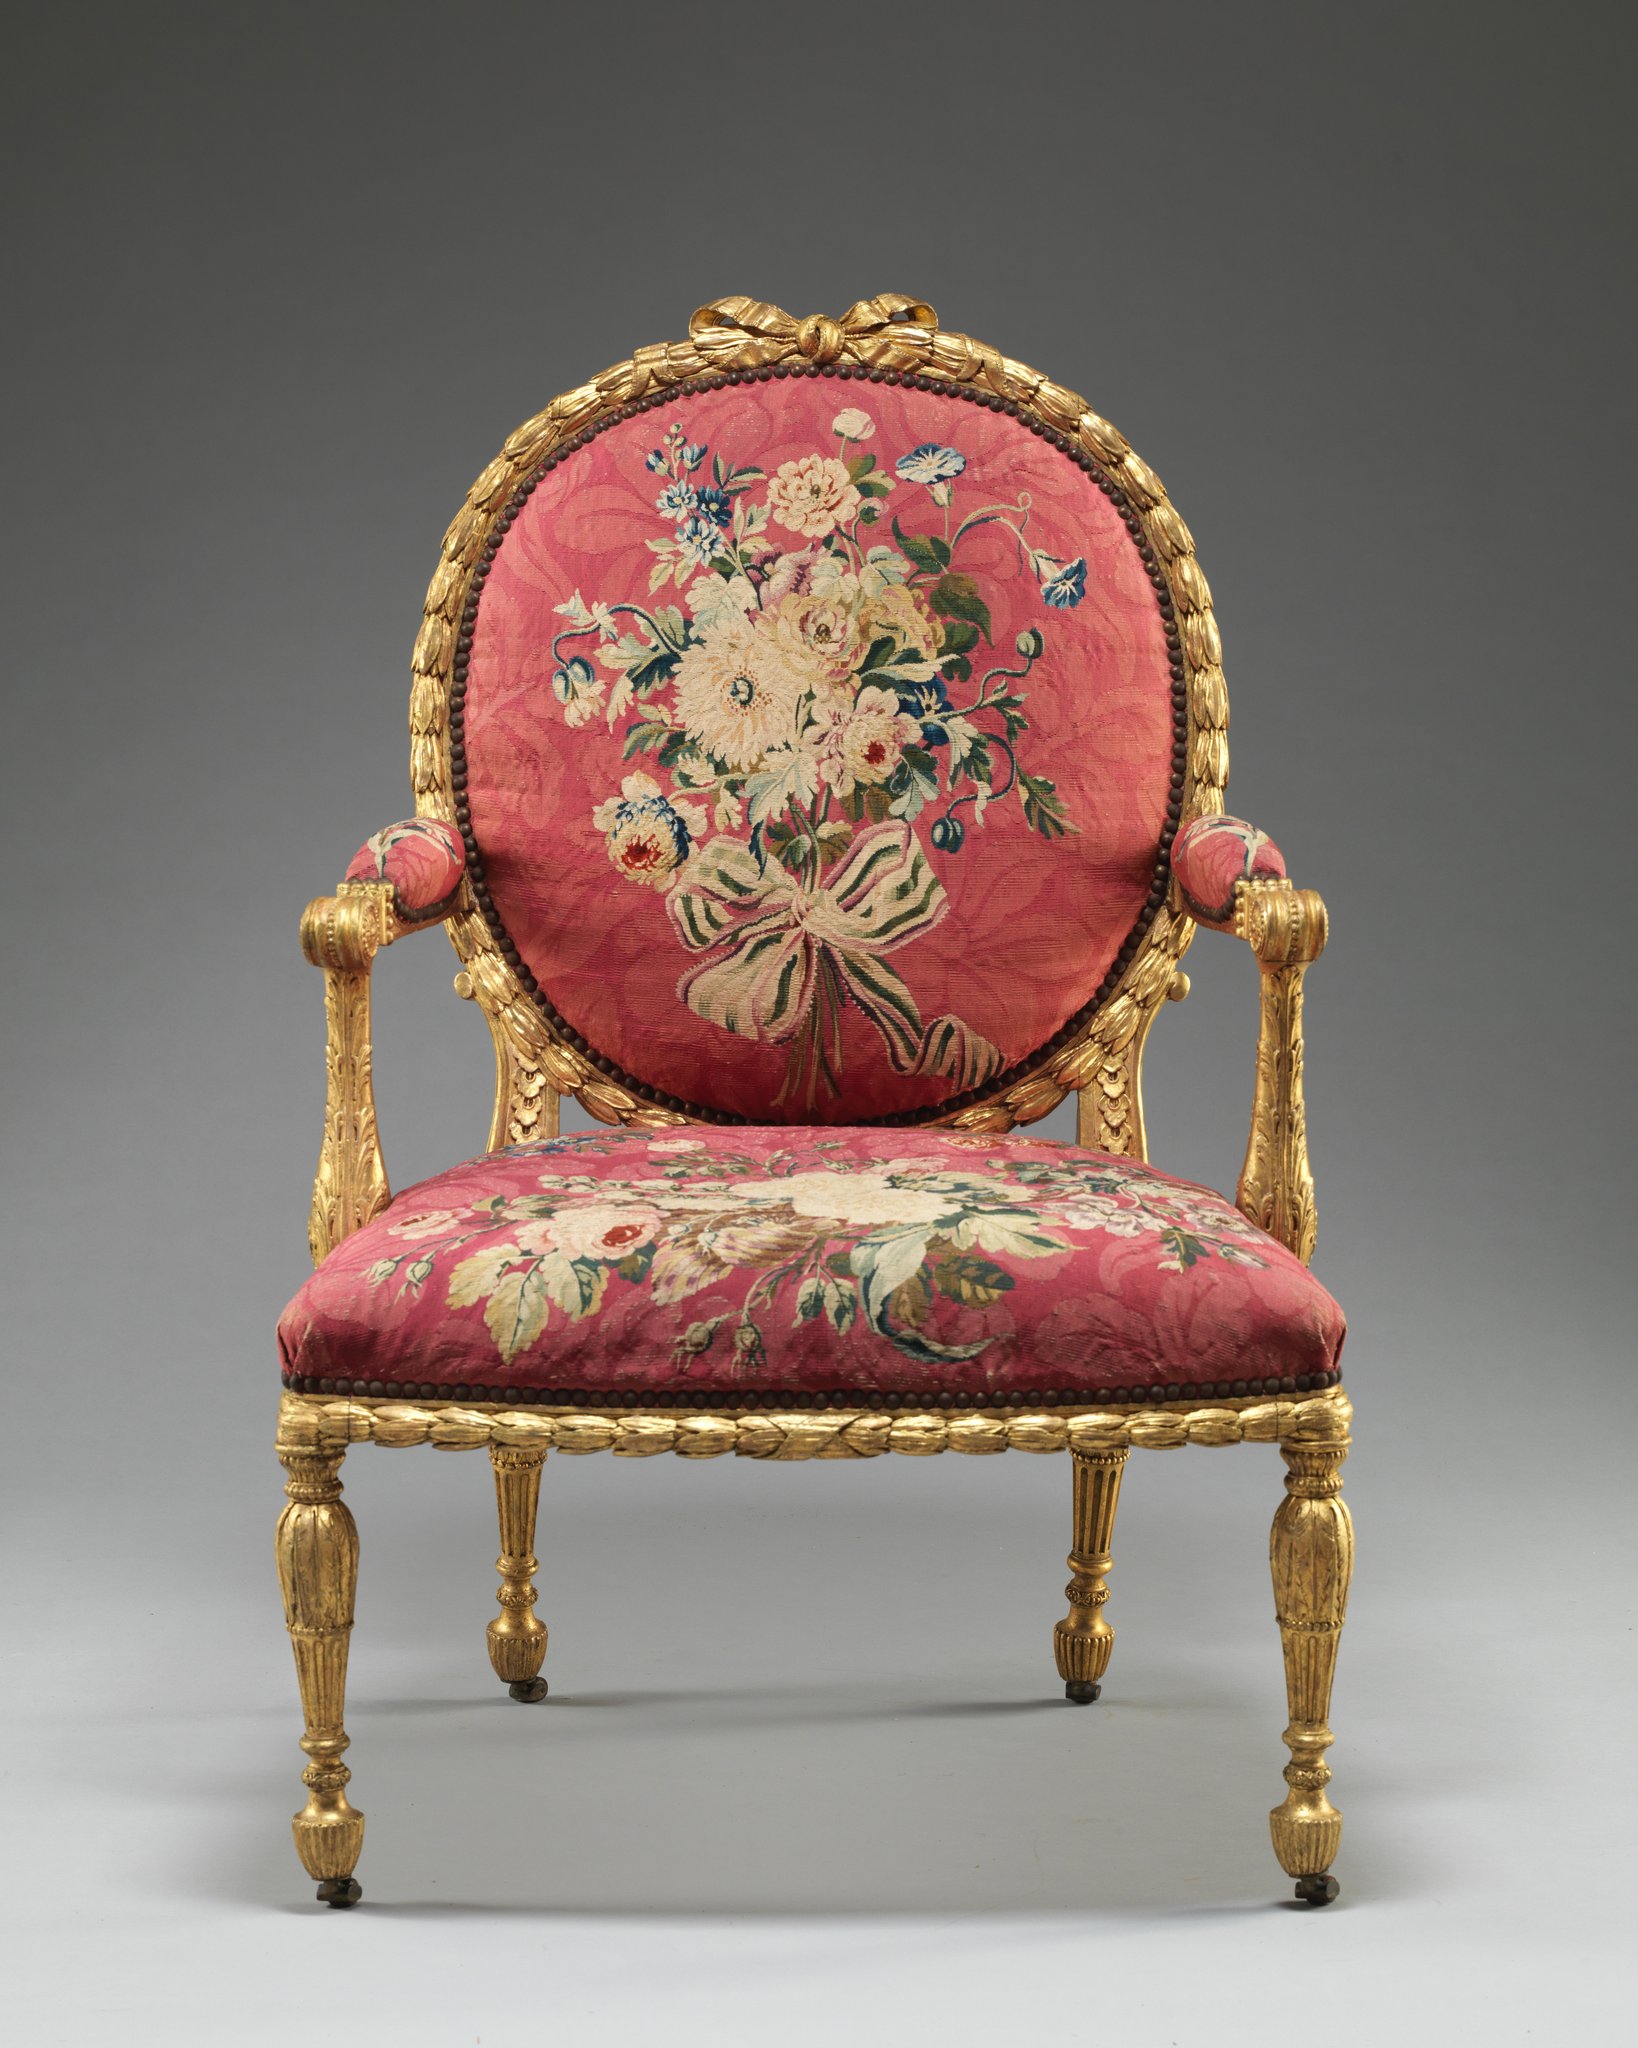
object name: armchair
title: Armchair (one of a set of six)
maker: john mayhew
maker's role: maker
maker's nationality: british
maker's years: 1736-1811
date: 1769-1771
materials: wood, silk, wool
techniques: gilding